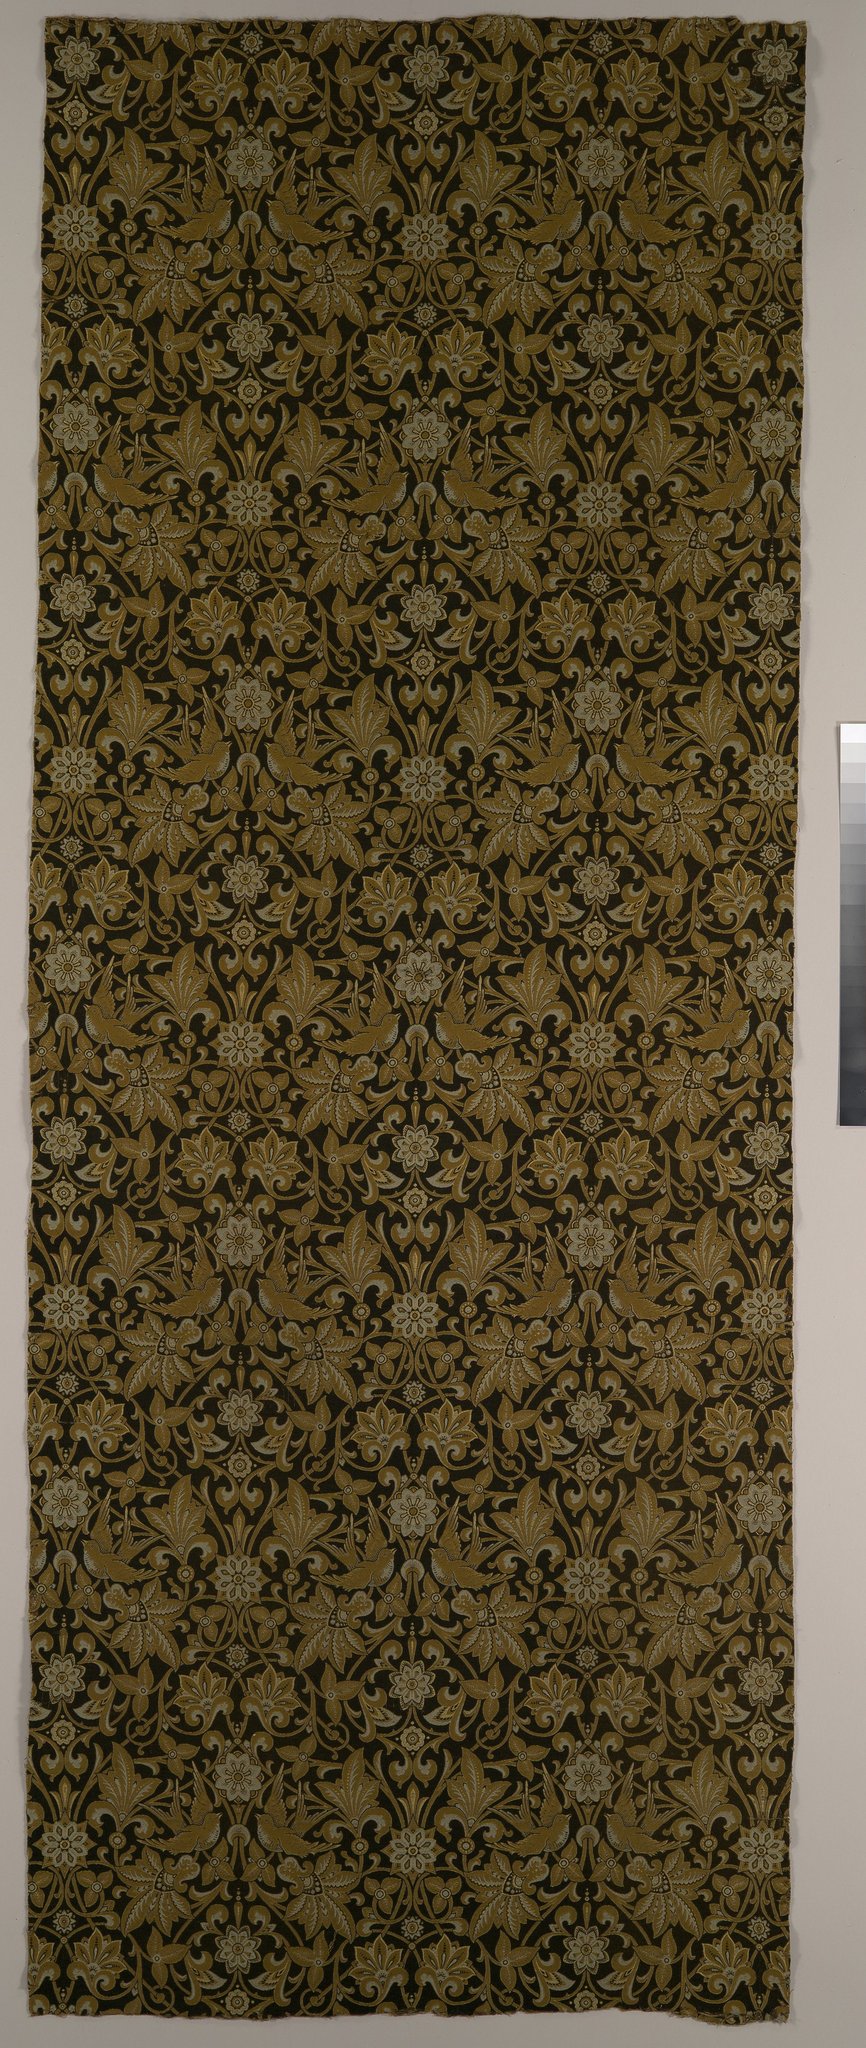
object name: panel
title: Chandos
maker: owen jones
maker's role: designer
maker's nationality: british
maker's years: 1809-1874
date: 1873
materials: cotton, silk, wool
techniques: weave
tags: birds,flowers